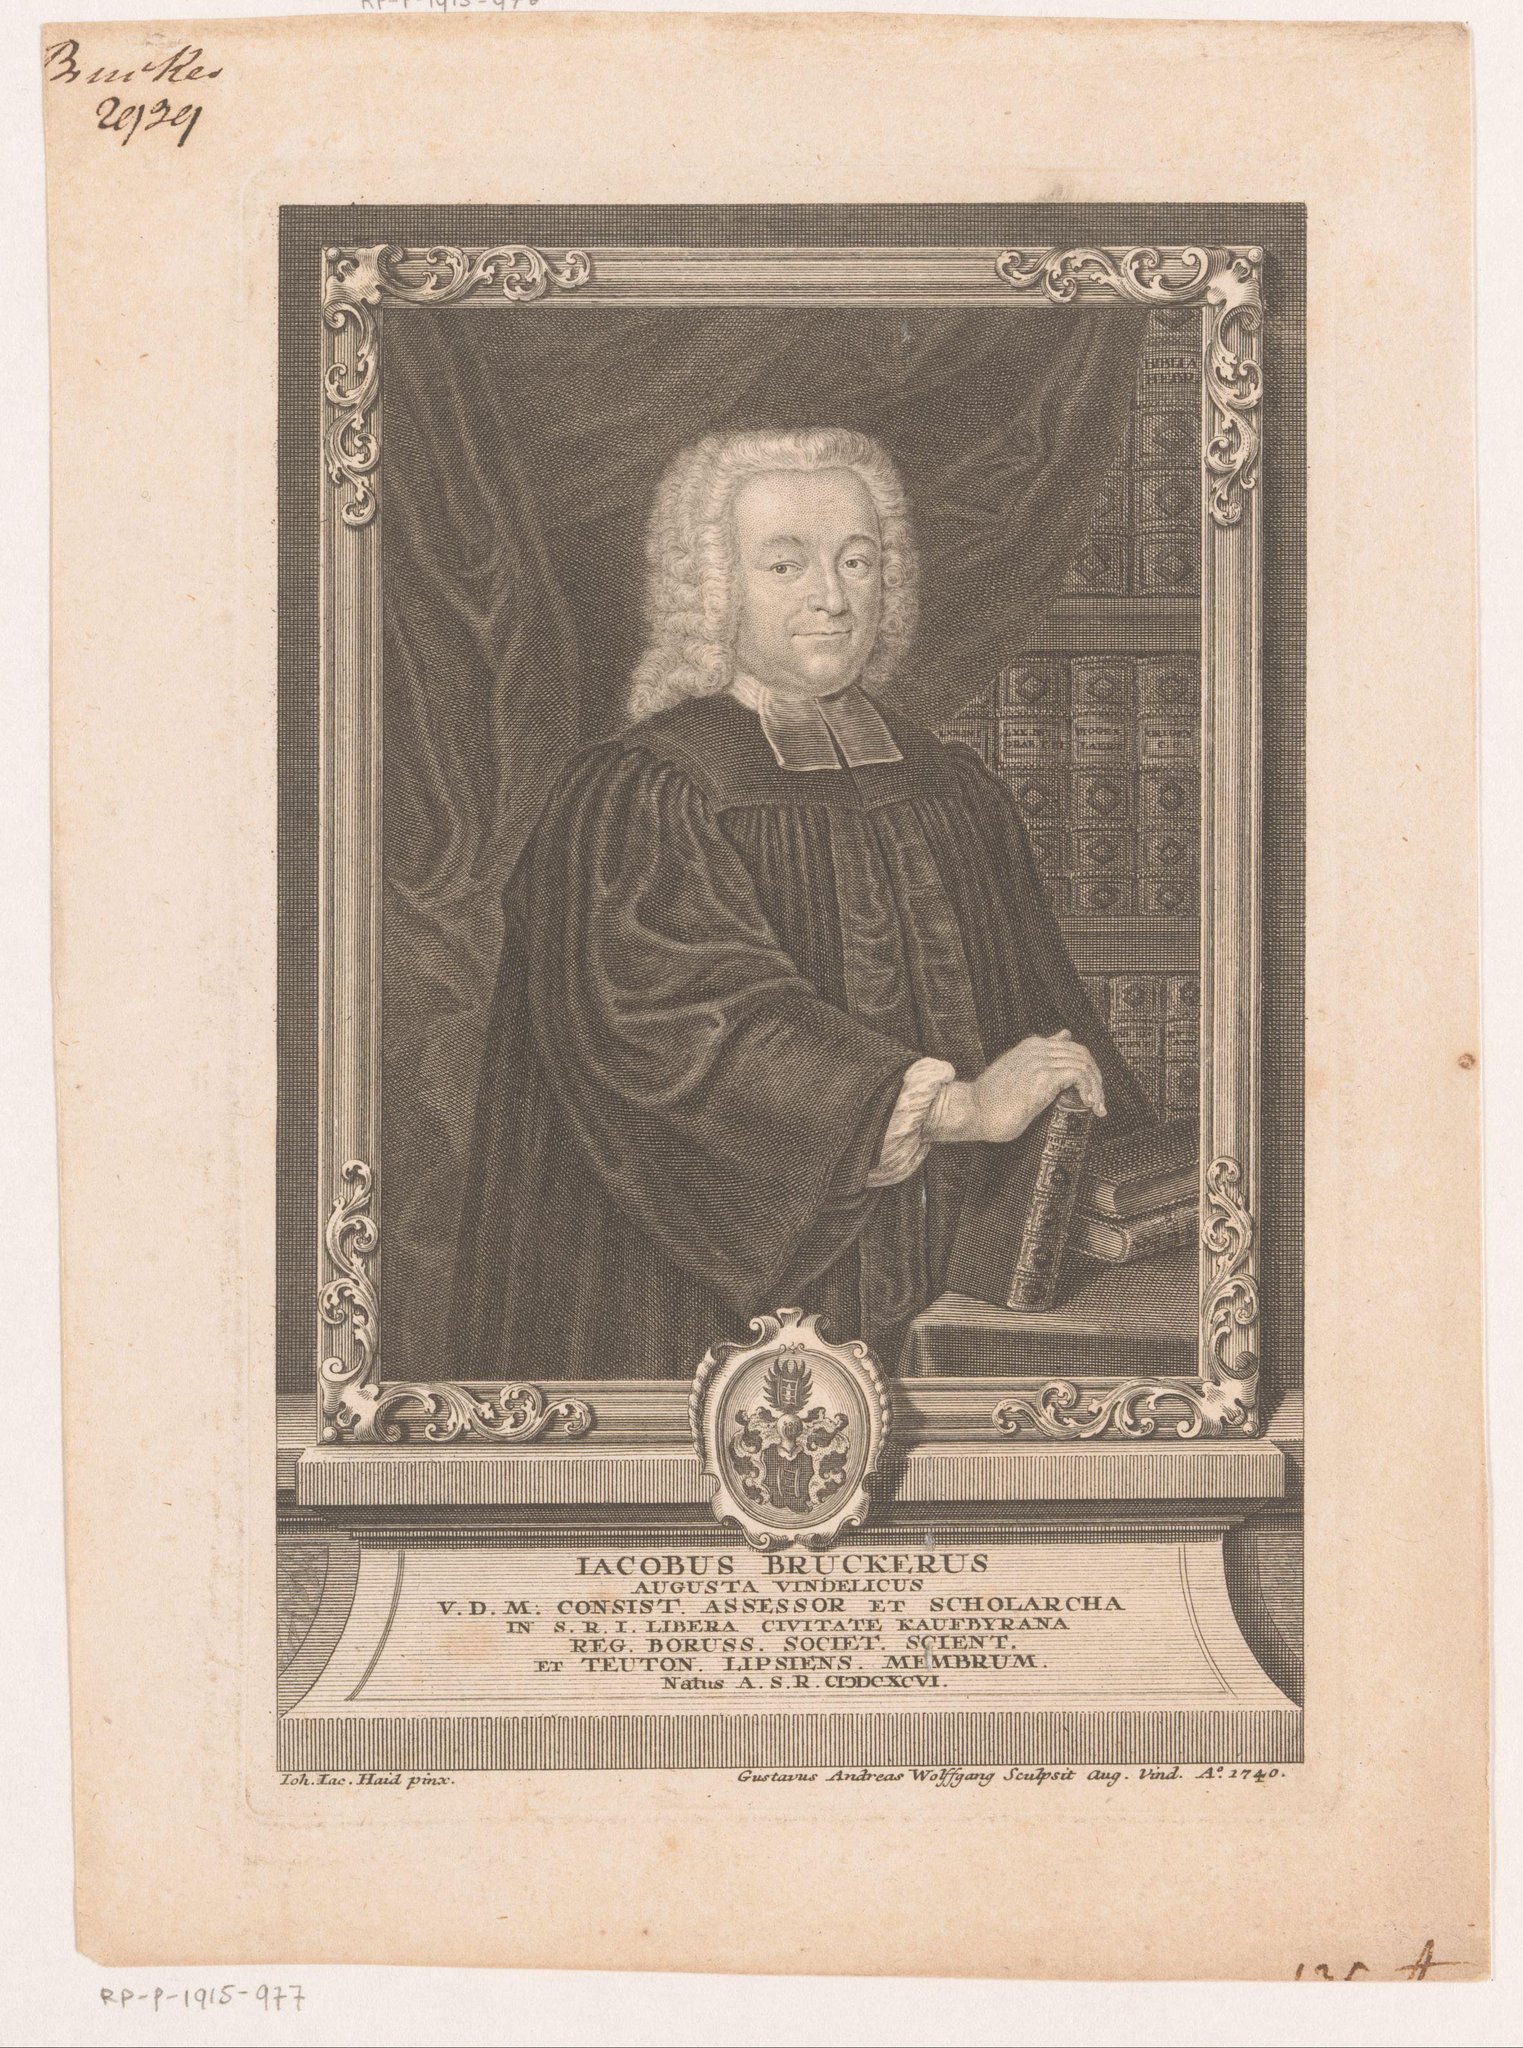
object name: print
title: Portret van Jacob Brucker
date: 1740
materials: paper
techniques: engraving, etching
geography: augsburg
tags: augsburg, jacob brucker, historical persons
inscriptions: collector's mark: Lugt 2228